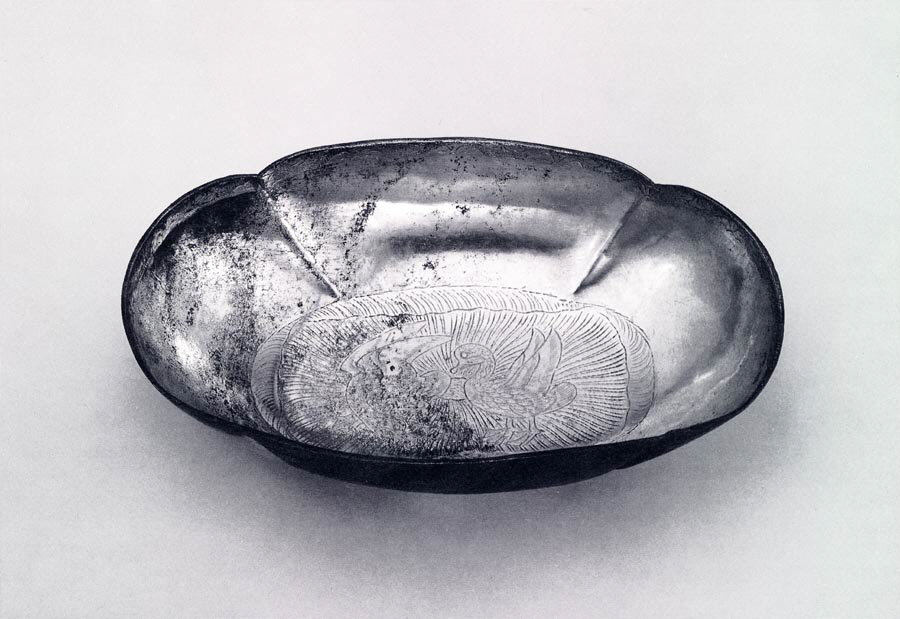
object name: wine cup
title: Wine cup with two ducks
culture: chinese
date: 701-900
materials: silver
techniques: gilding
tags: ducks